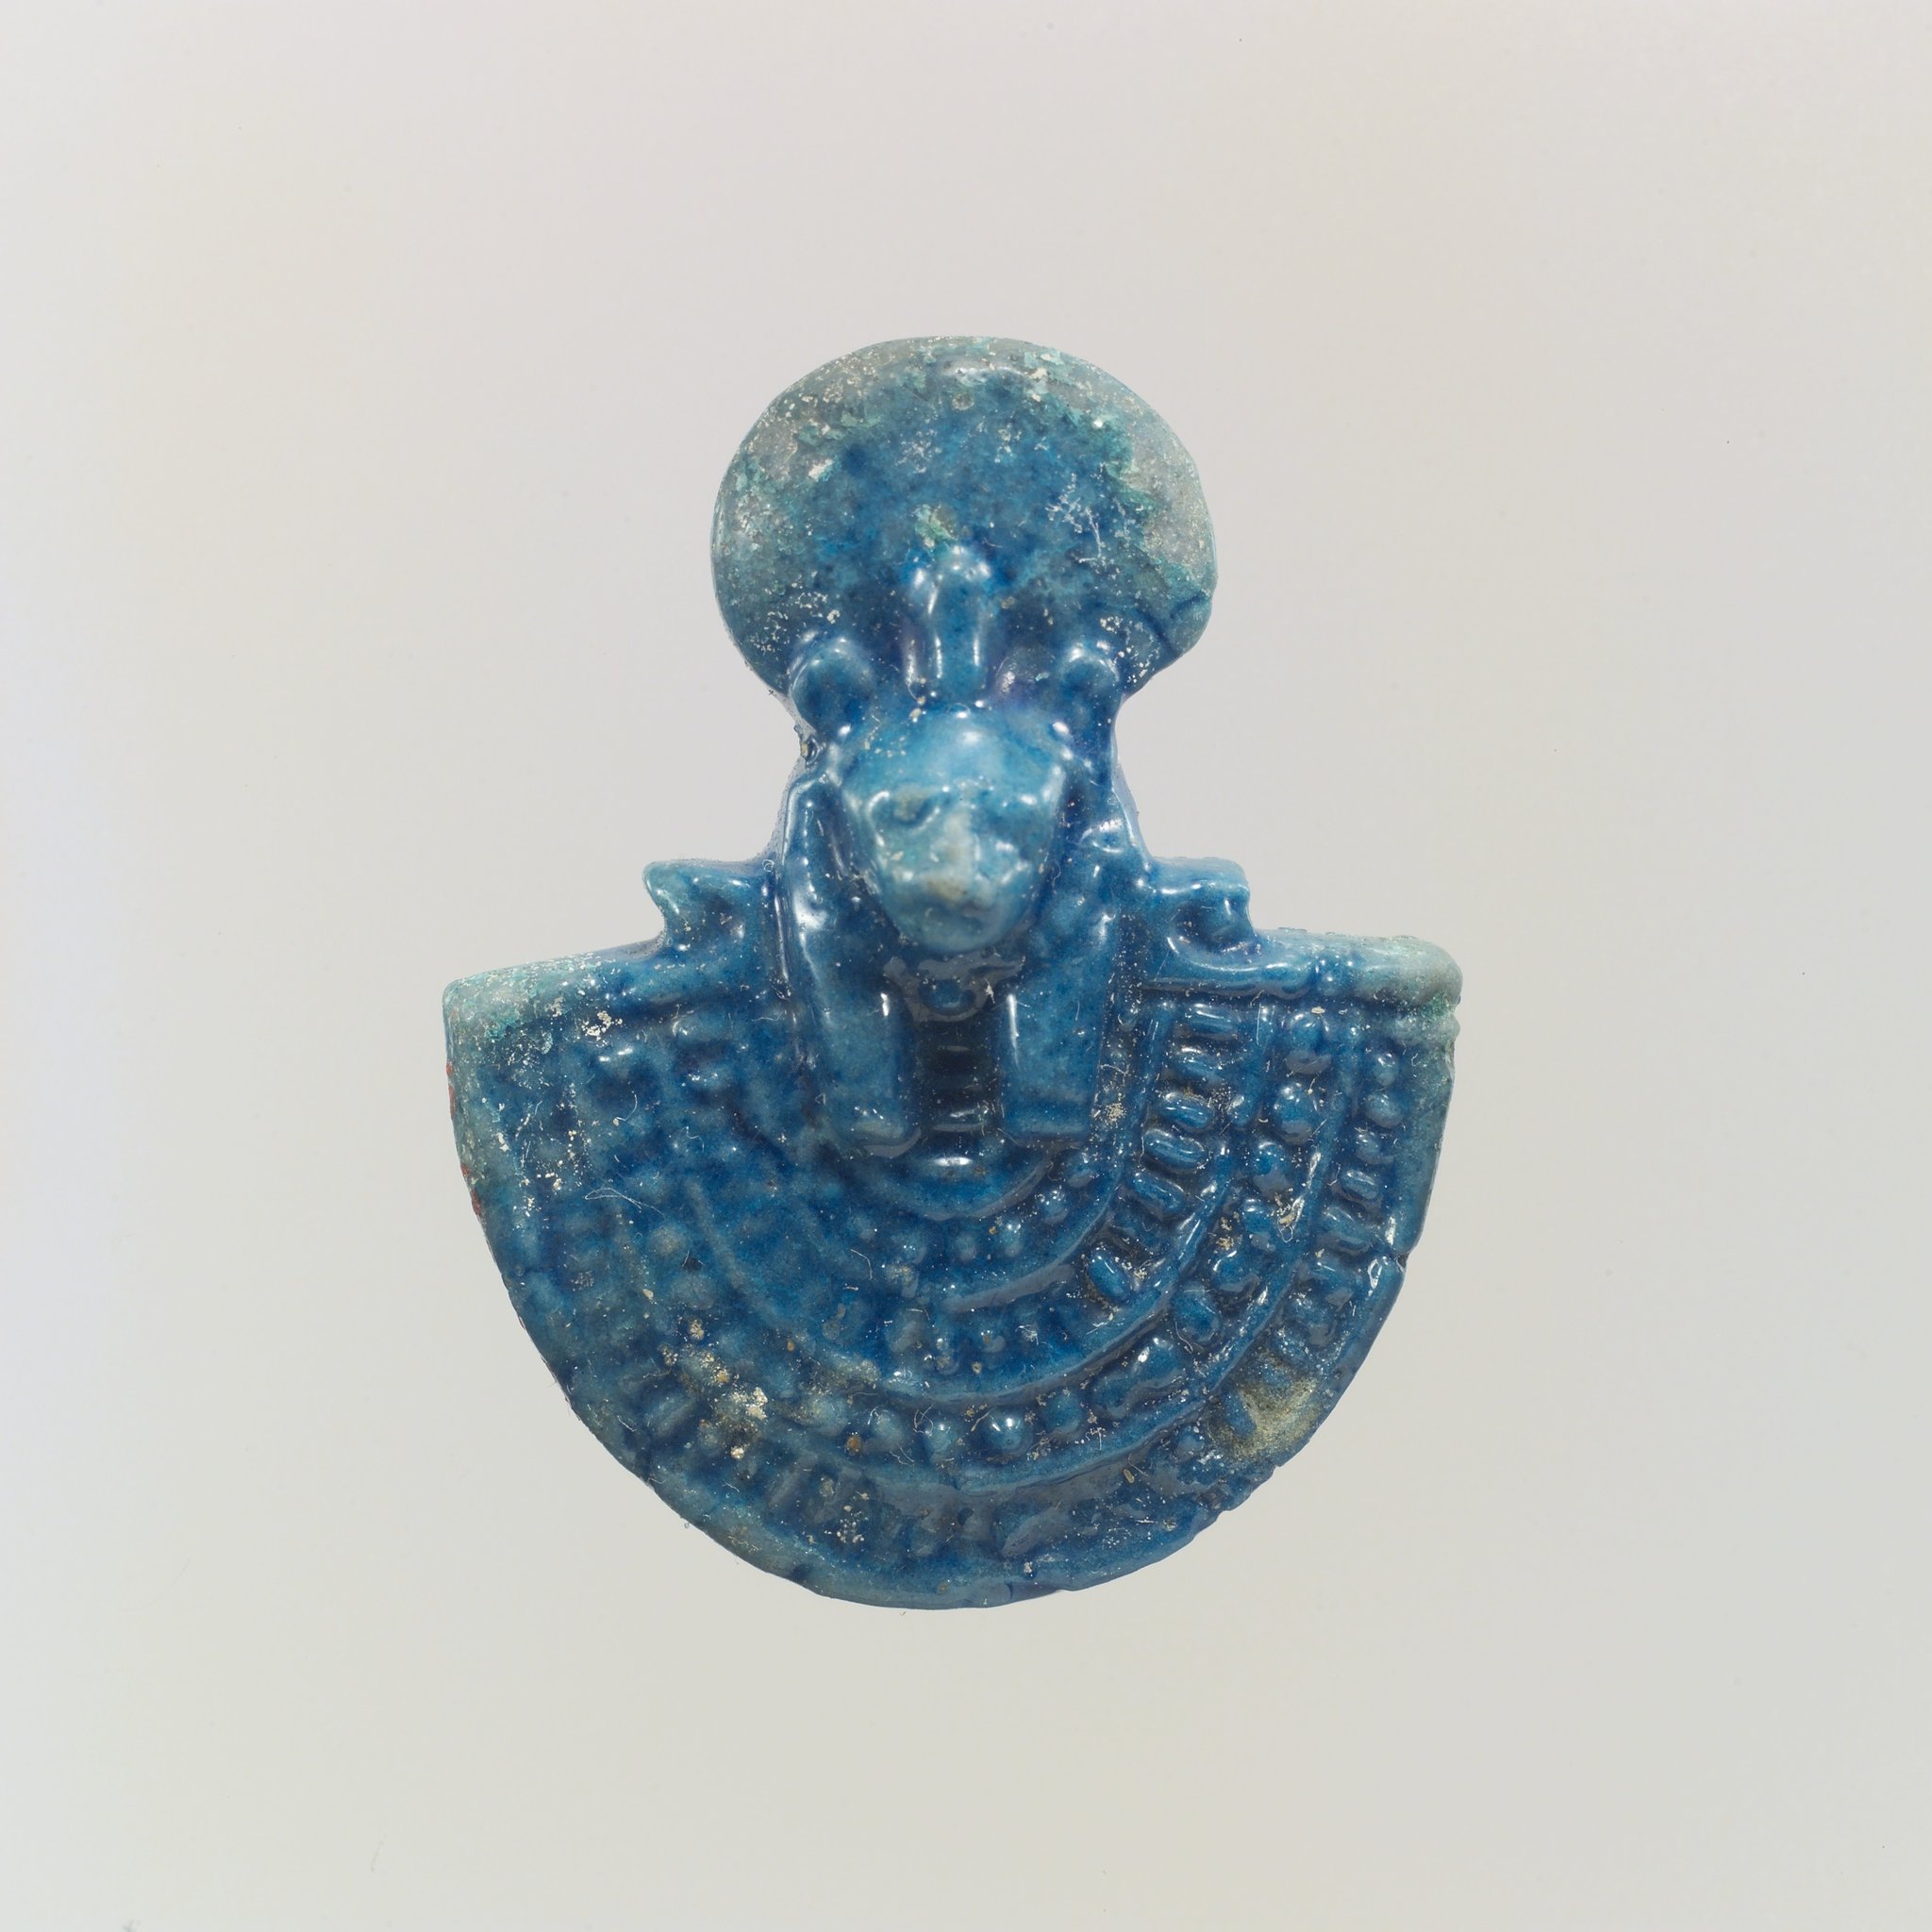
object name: amulet, aegis, bastet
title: Aegis of Sakhmet or Bastet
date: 664-630 BCE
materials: faience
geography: egypt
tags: sekhmet